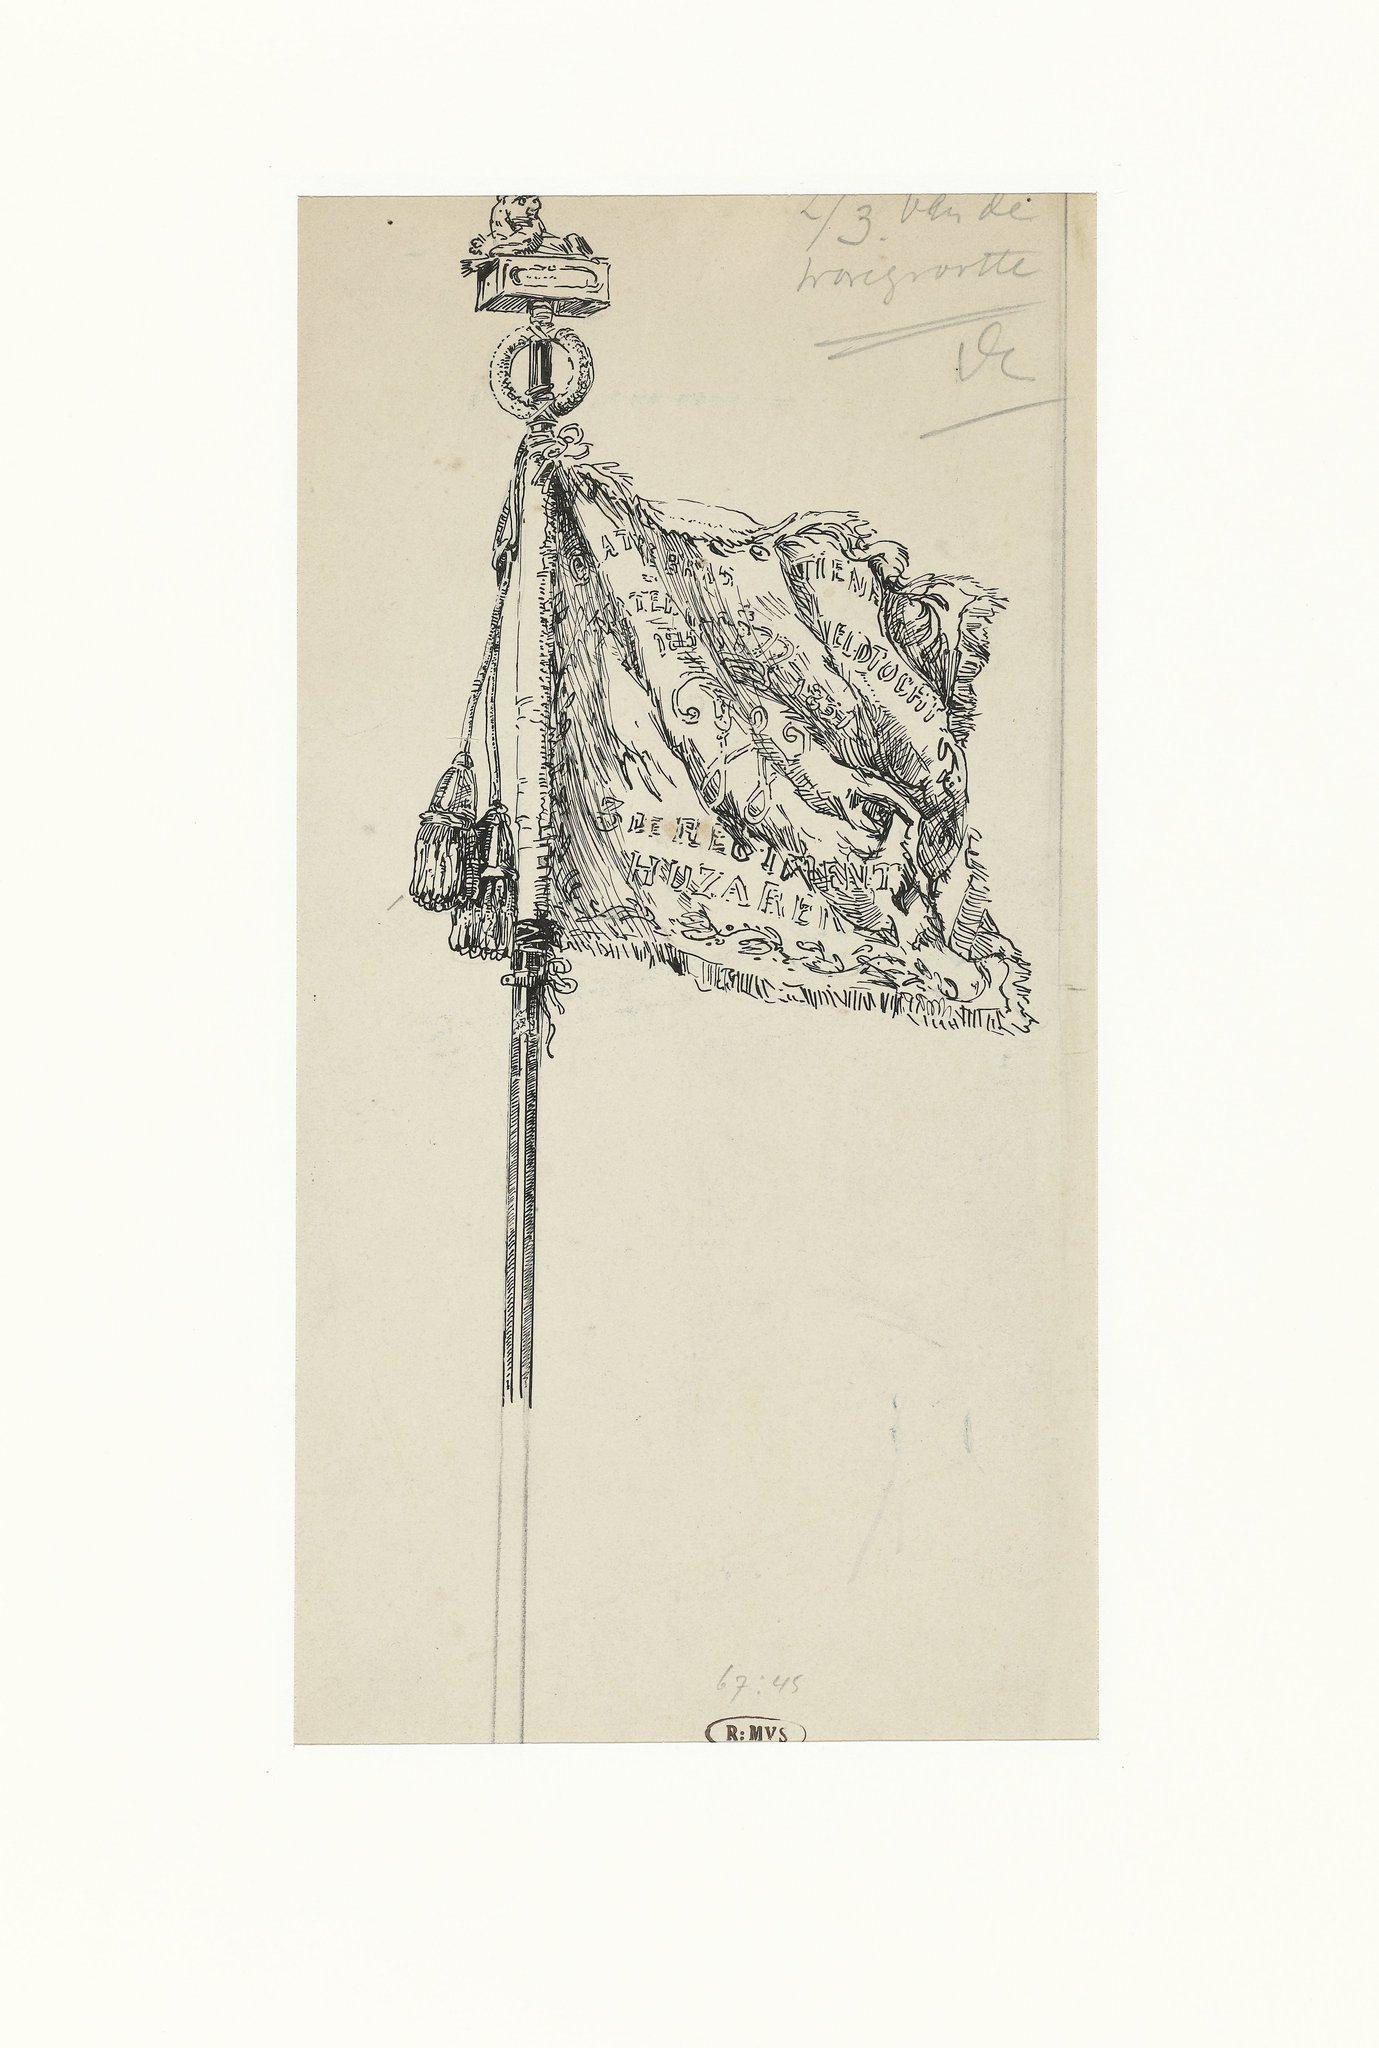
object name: drawing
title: Standaard van het Derde Regiment Huzaren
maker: jan hoynck van papendrecht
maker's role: draughtsman, painter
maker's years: 1858-1933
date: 1868-1933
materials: ink, paper, pencil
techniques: pen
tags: insignia of companies, etc. (+ cavalry, horsemen), the hague